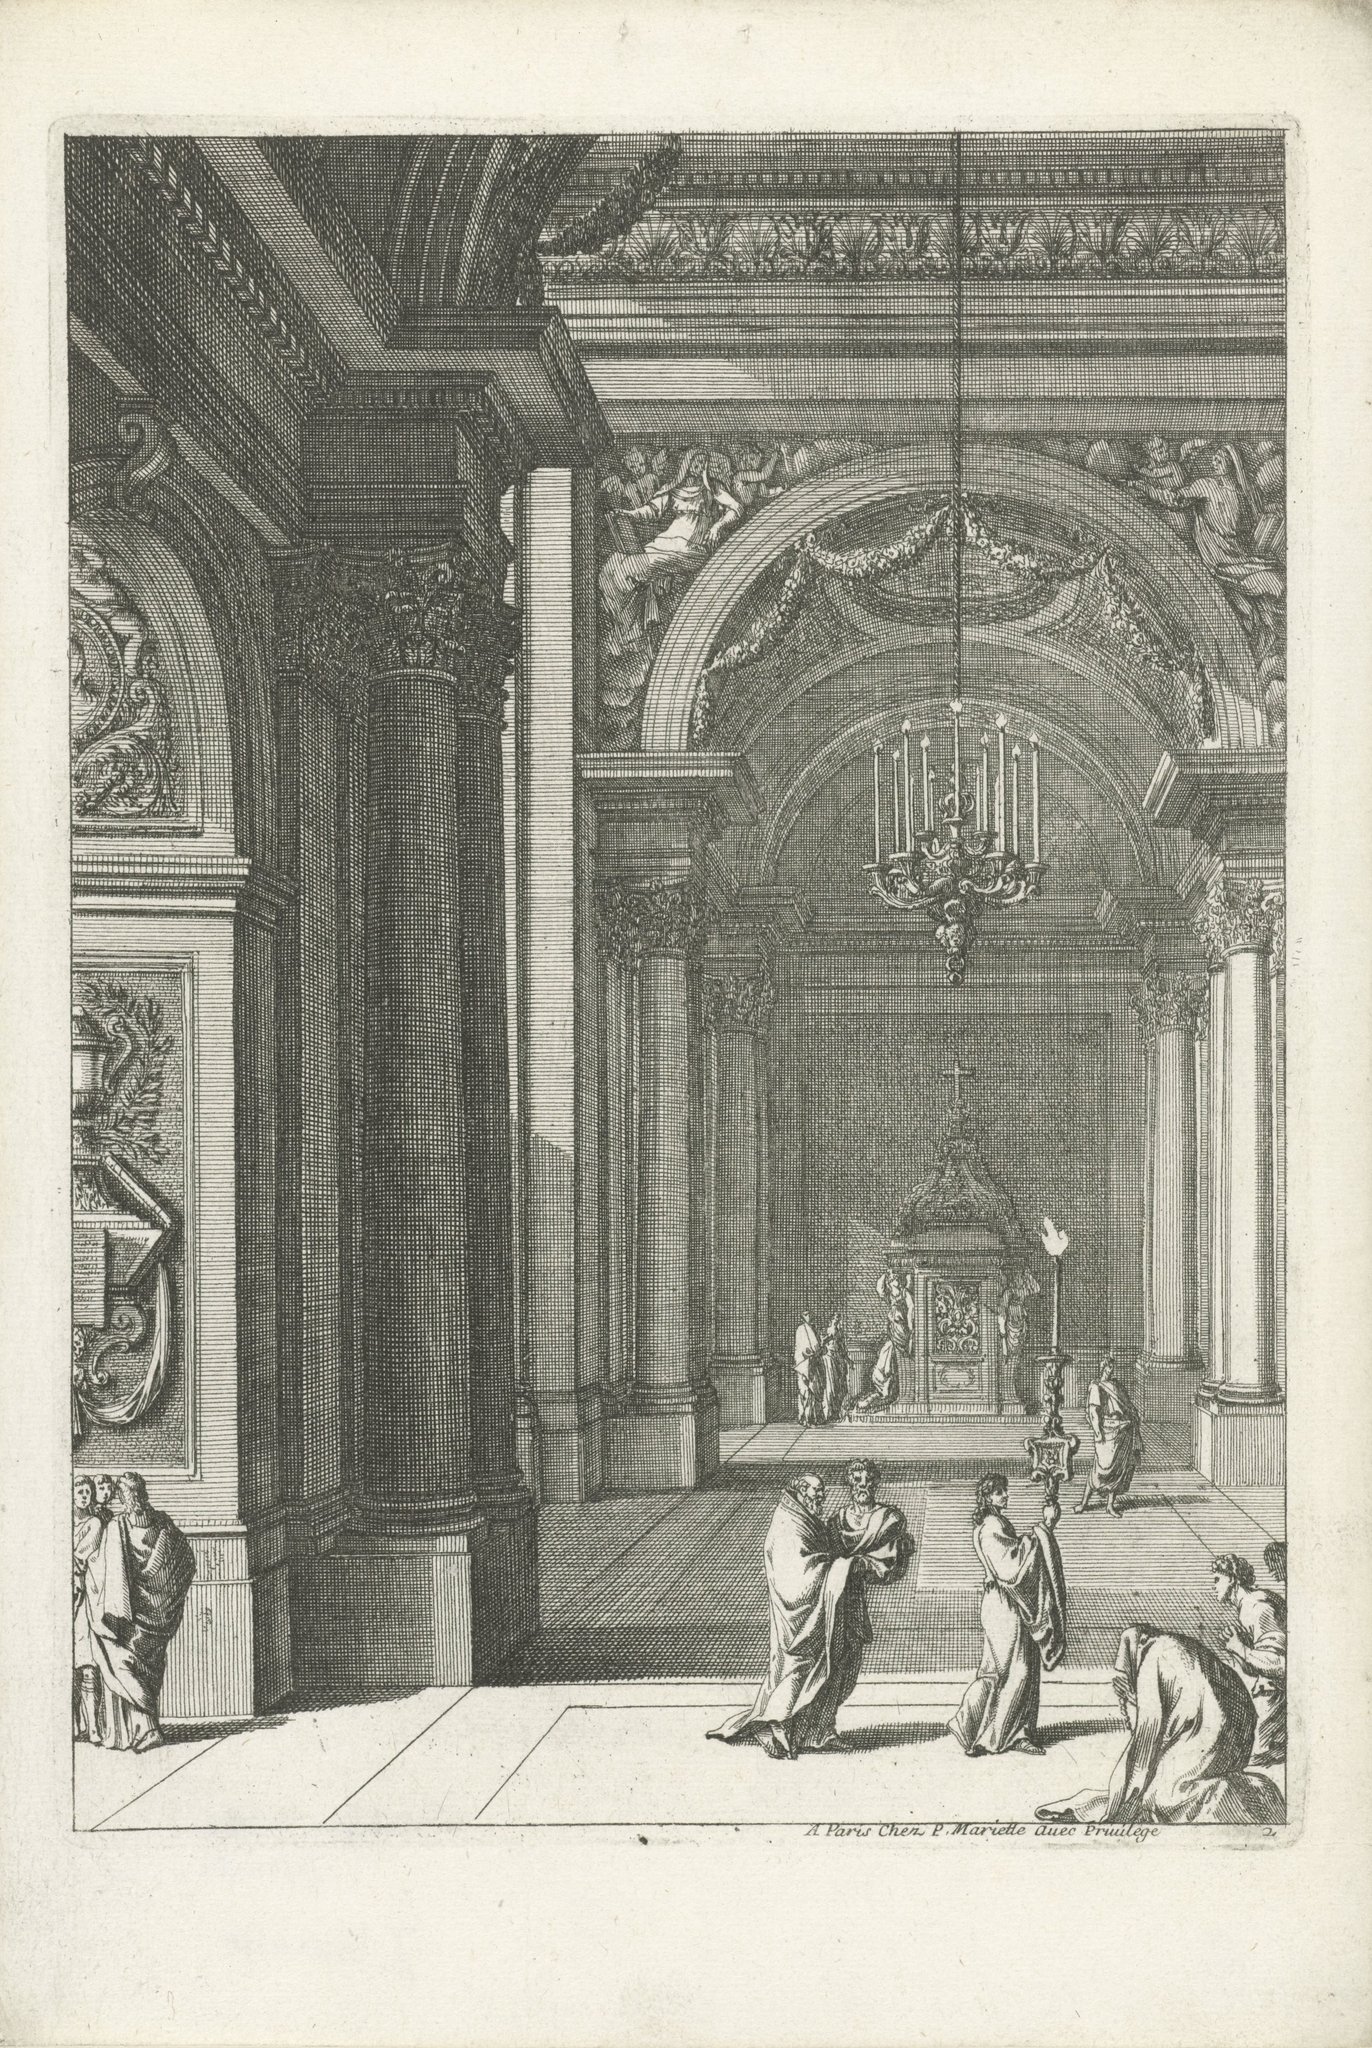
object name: ornament print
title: Confessionaux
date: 1658-1670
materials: paper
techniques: etching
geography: france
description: Uitzicht op een nis in het gangpad van een kerk waarin een biechtstoel staat.